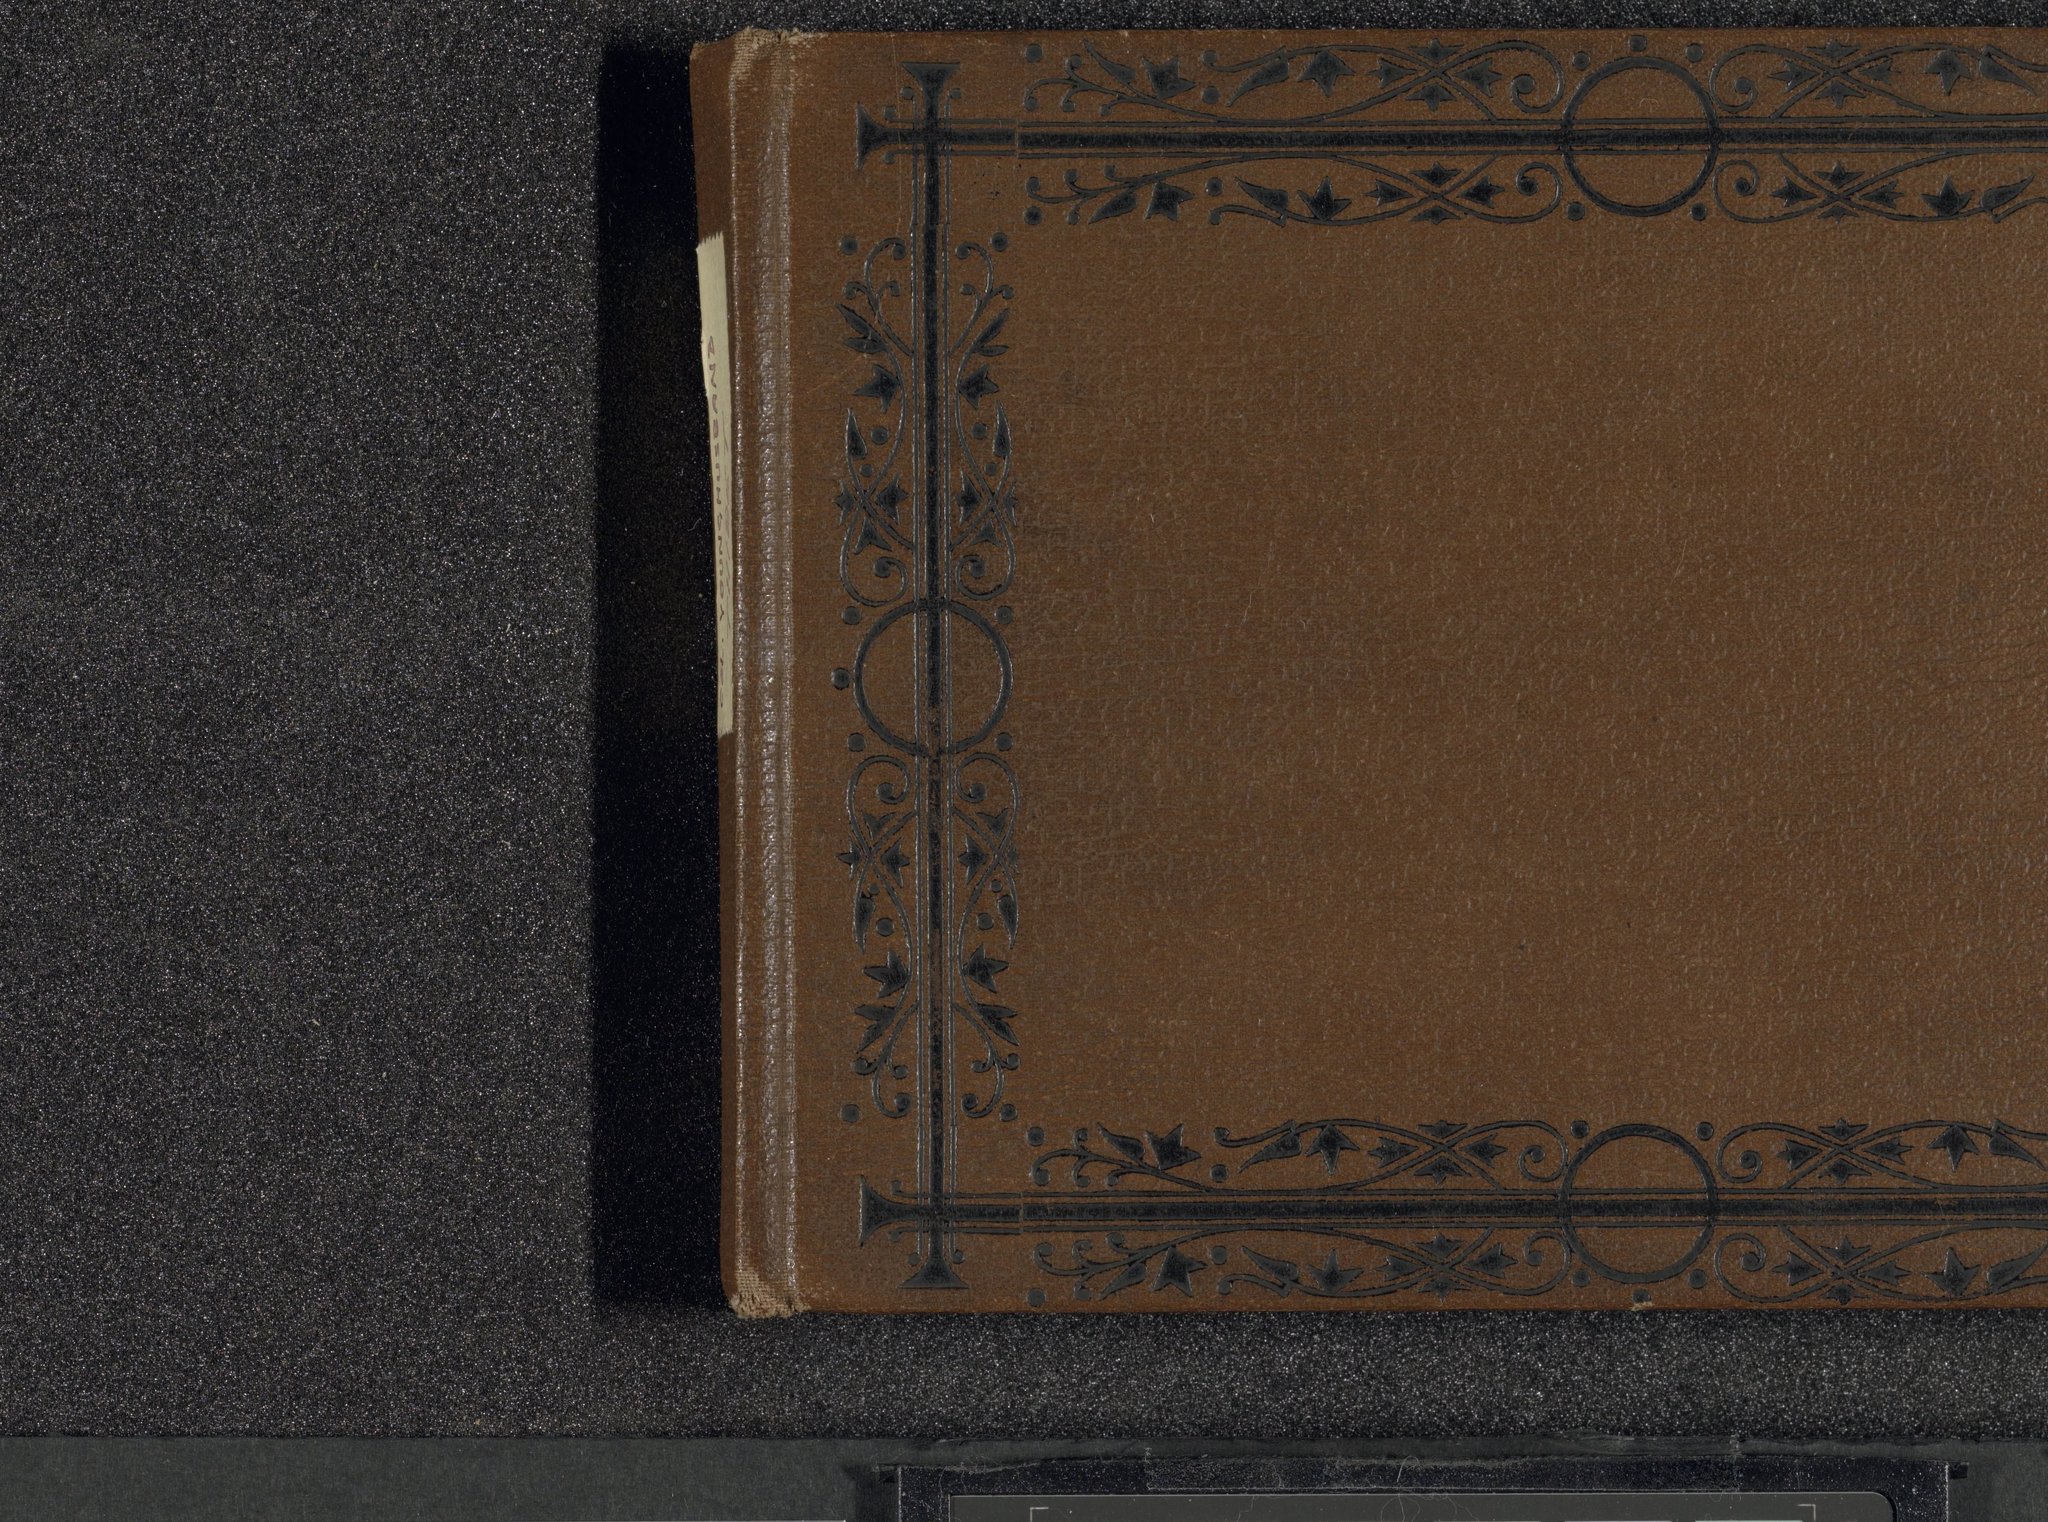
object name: slip in album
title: Col. Younghusband Thibet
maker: d.t. dalton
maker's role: sergeant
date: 1903-1906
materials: cardboard, paper, photographic support, textile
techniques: gelatin silver print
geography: tibet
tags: imperialism, travelling; tourism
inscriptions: label: ‘Col. Younghusband Thibet’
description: Fotoalbum in een bruin omslag. Op de voorzijde een zwart kader versierd met plantmotieven. Op de rug van het album is een label geplakt met daarop handgeschreven 'Col. Younghusband Thibet'. Op de binnenzijde van de voorkant staat handgeschreven 'The Roof of The World or Tibet 1906 DT Dalton'. Het album bevat 12 kartonnen bladzijden met 24 foto's in omkaderde passe-partouts. de onderschriften zijn met de hand geschreven, de jaartallen zijn vermoedelijk later toegevoegd. Bij het album is een brief gevoegd met herkomstgegevens. De foto's zijn gemaakt door legertelegrafist sergeant D.T. Dalton tijdens en na de Britse veldtocht in Tibet onder leiding van kolonel Frances Younghusband (1903-1904).